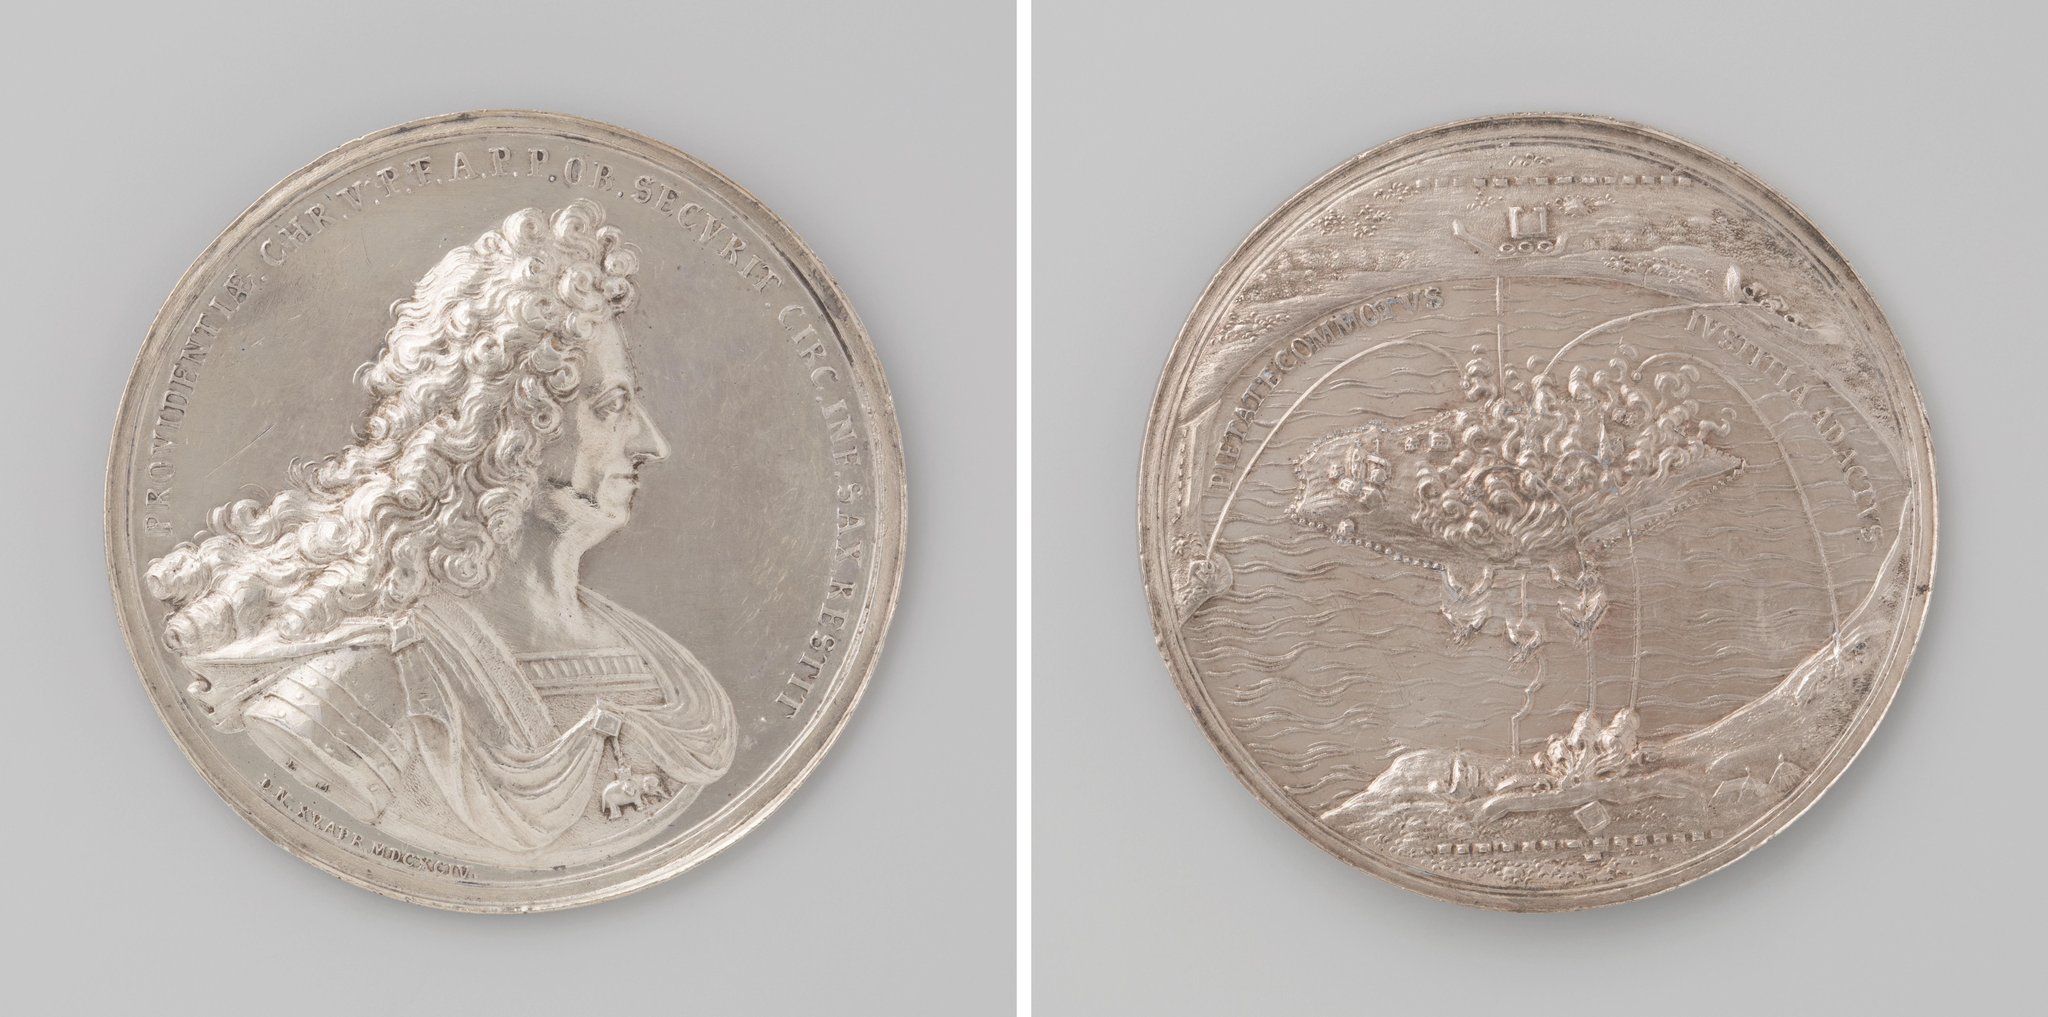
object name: history medal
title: Bombardement van Ratzeburg door Christiaan V, koning van Denemarken, penning door de kroonprins aangeboden aan zijn vader op diens verjaardag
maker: barthold meyer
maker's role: medailleur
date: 1694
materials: silver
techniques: striking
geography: dömitz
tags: copenhagen (city)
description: Zilveren penning. Voorzijde: borststuk man binnen omschrift. Keerzijde: bombardement van stad